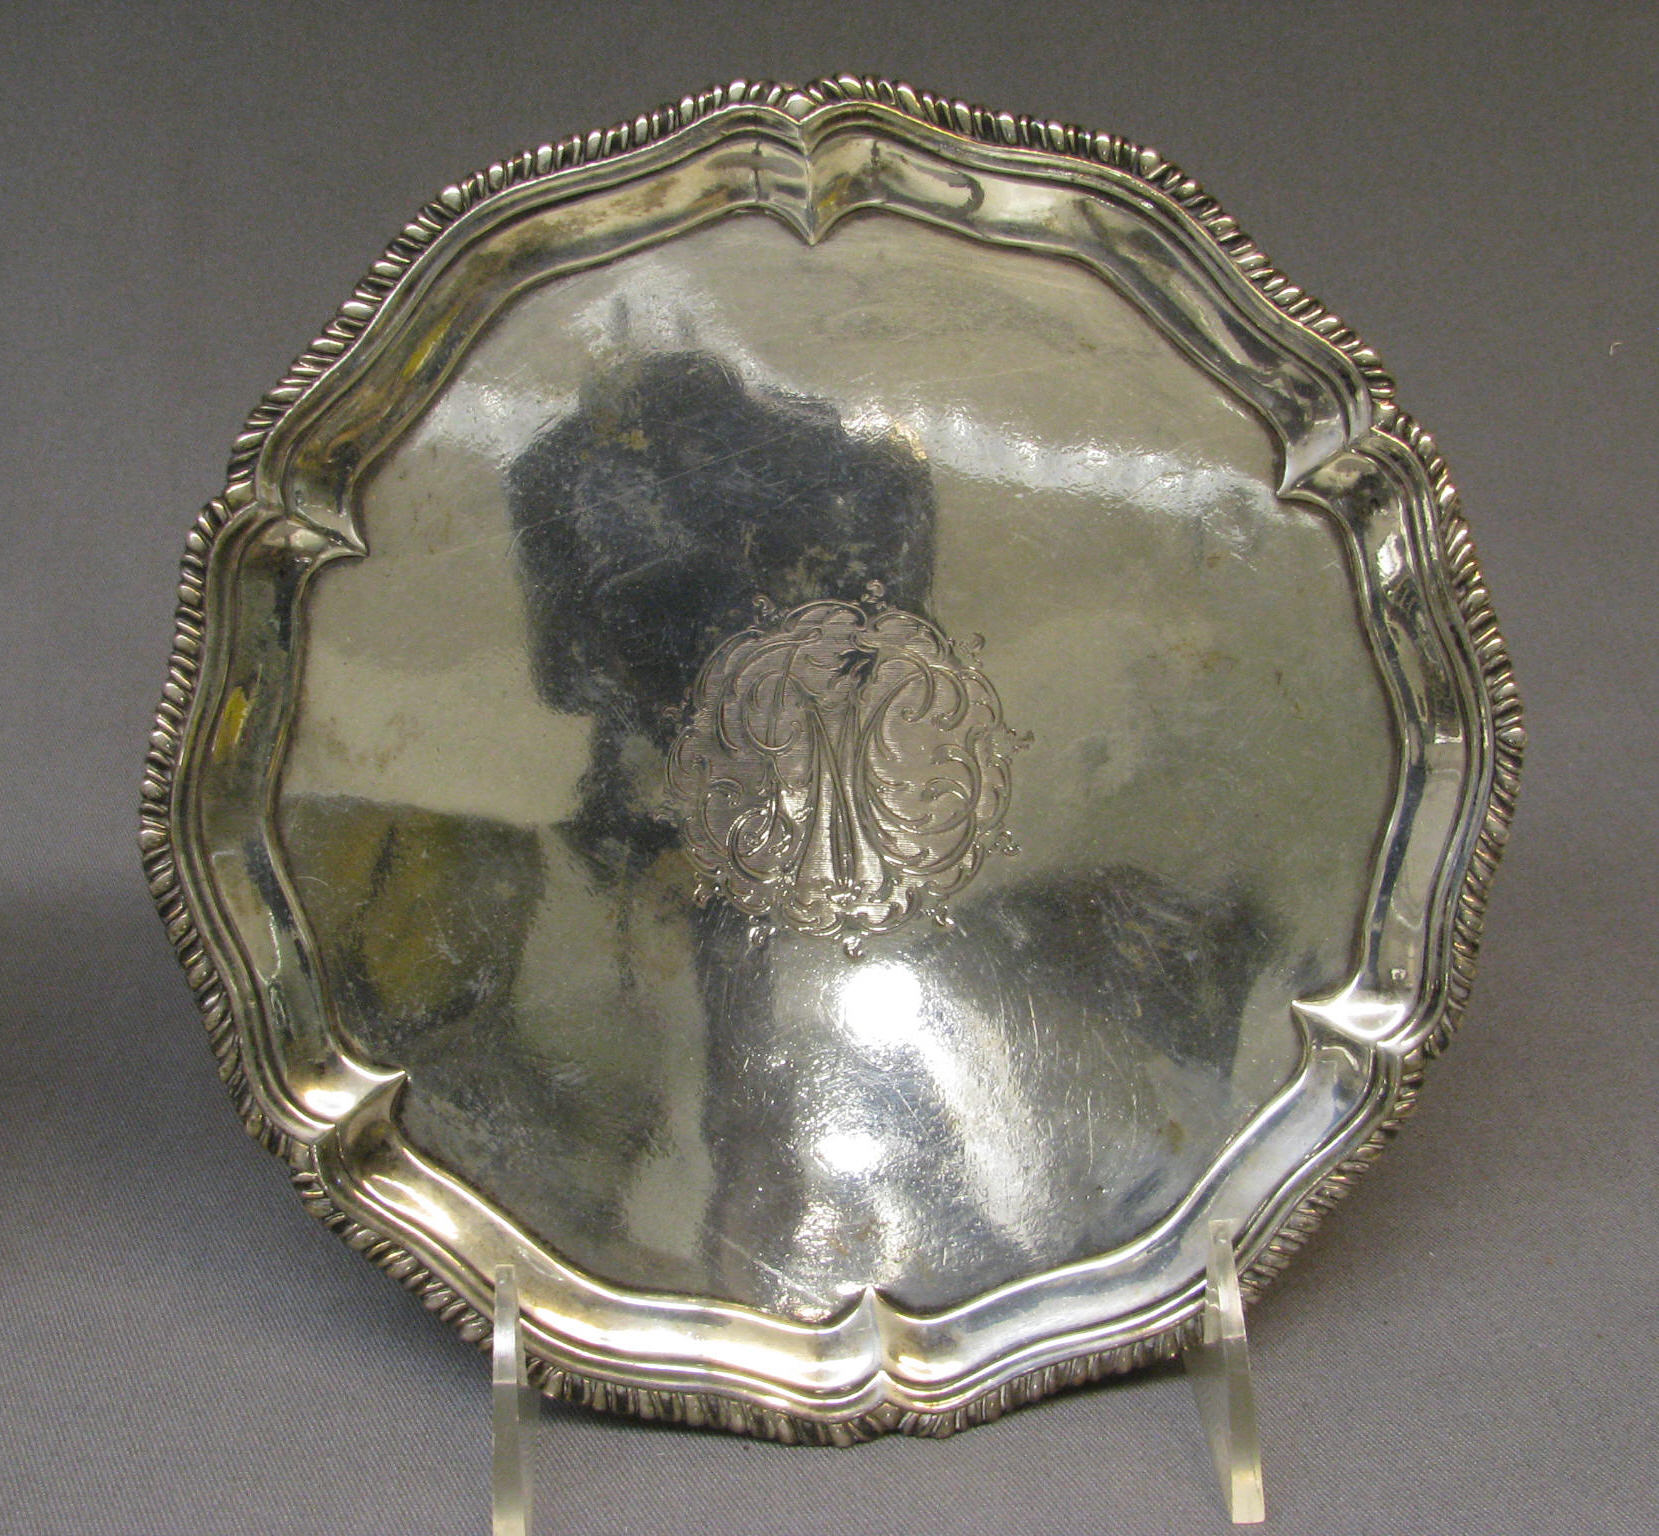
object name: salver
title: Salver (one of a pair)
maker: thomas hannam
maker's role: maker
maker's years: 1700-1800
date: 1764-1765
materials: silver